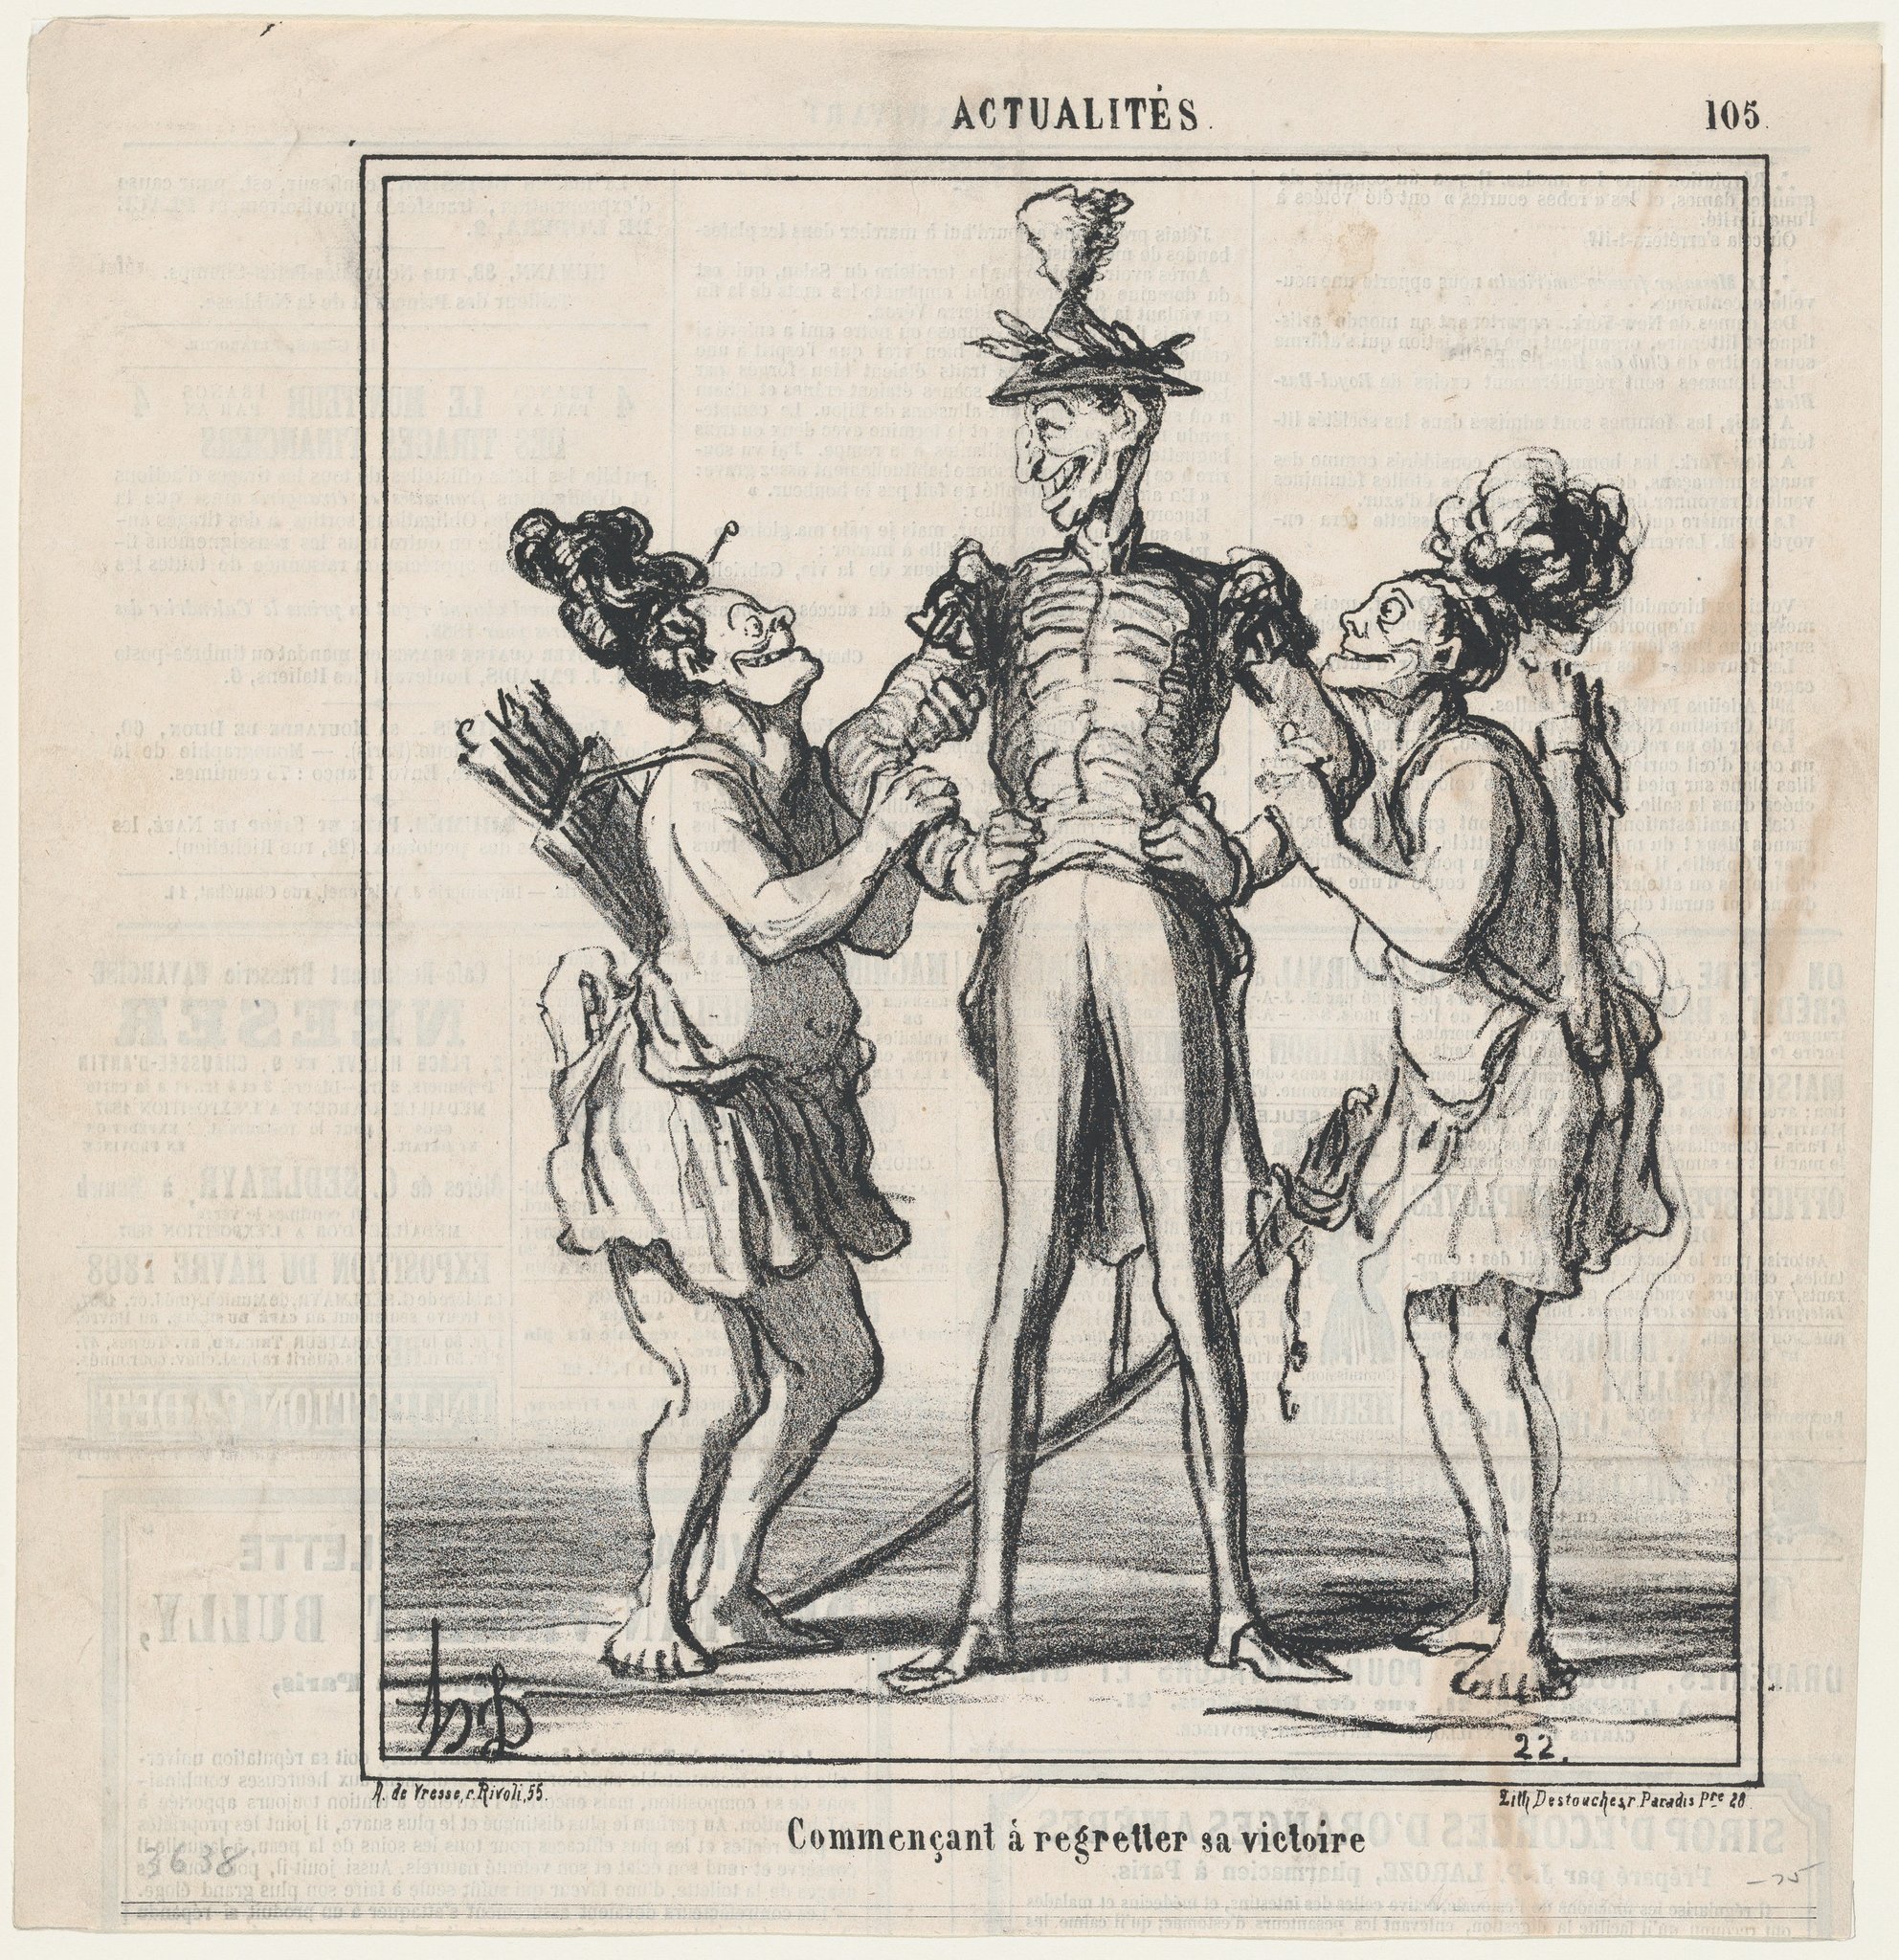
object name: print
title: Beginning to regret his victory, from 'News of the day,' published in Le Charivari, May 4, 1868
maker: honoré daumier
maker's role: artist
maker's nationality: french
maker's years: 1808-1879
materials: paper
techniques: lithograph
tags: satire,men,women